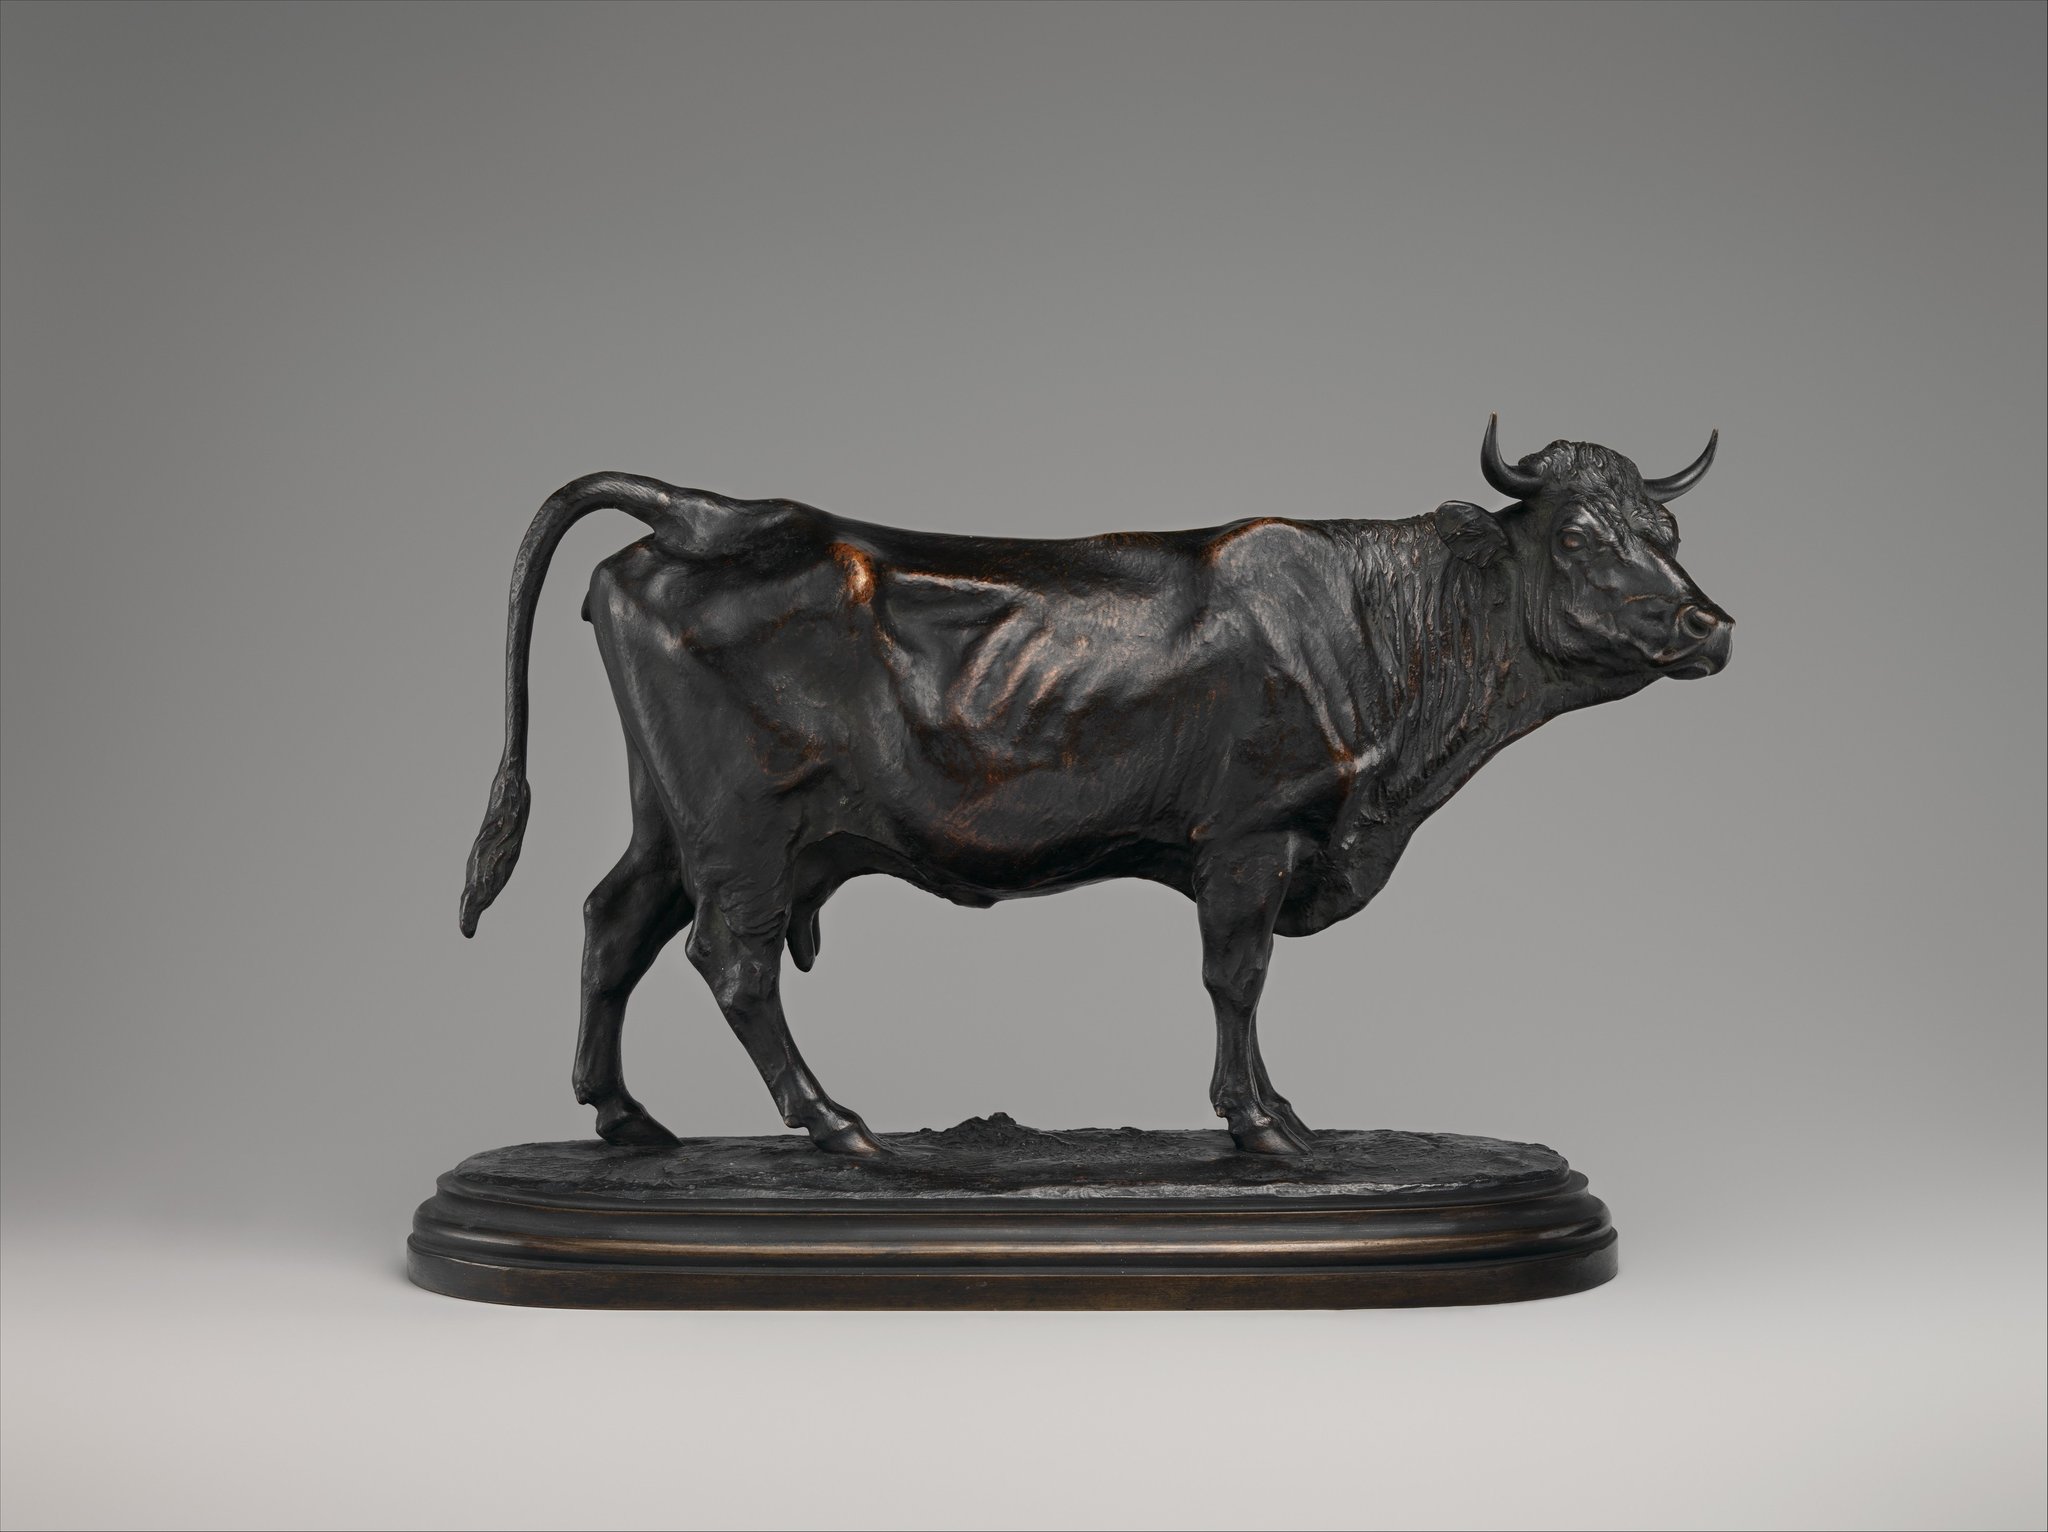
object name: statuette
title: Cow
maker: isidore bonheur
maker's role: artist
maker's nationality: french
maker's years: 1827-1901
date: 1801-1900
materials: bronze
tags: cows